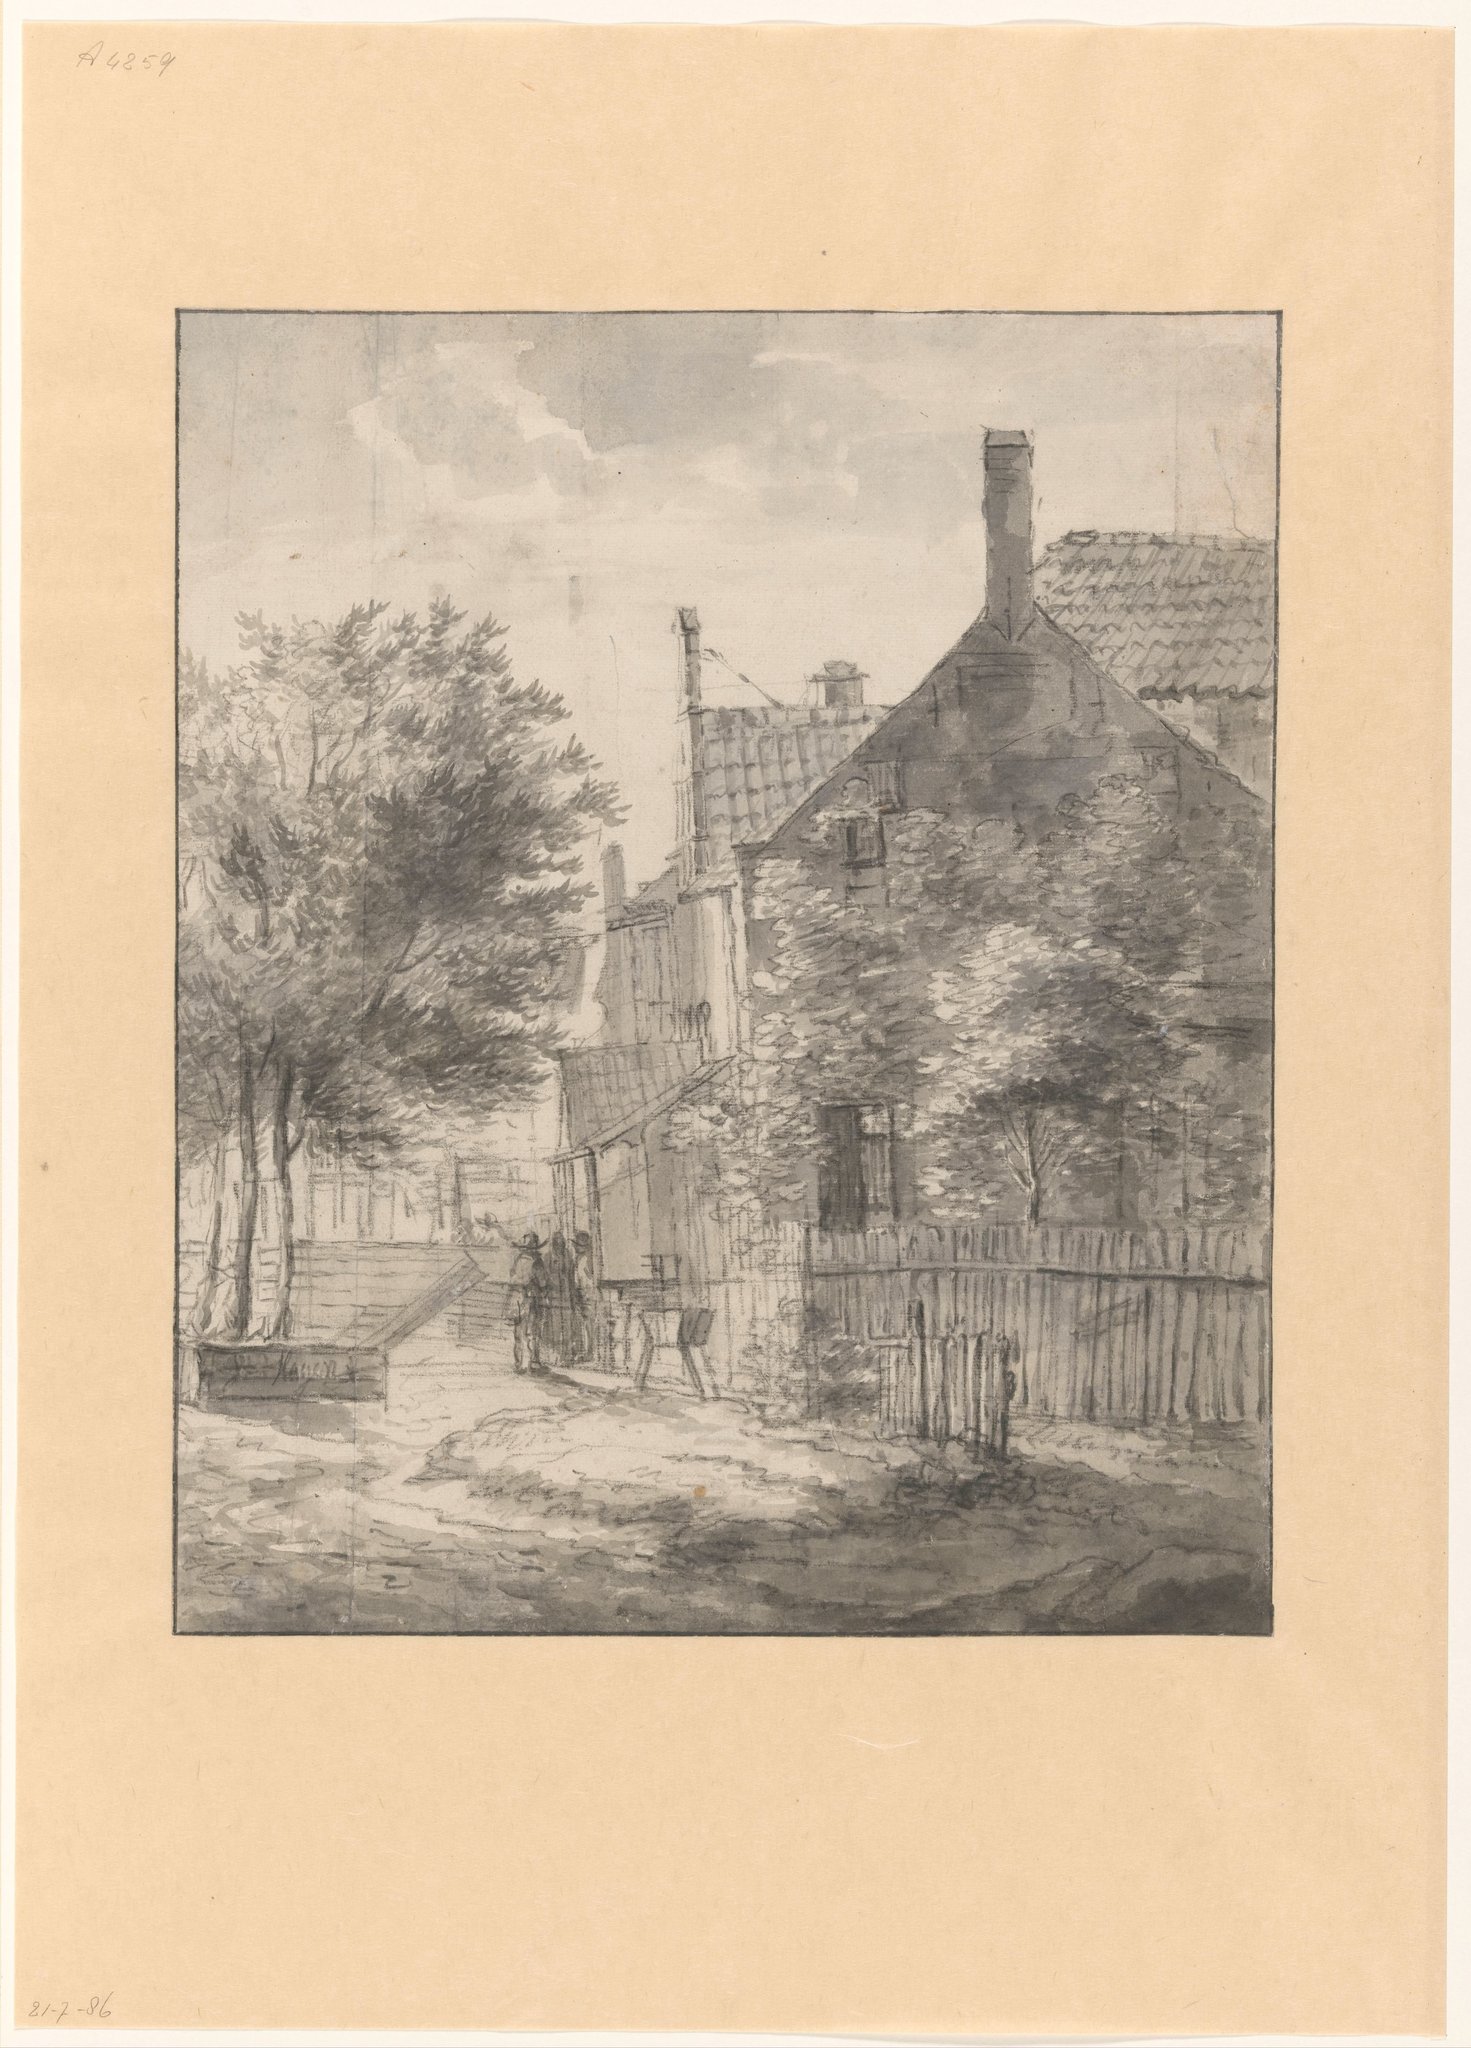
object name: drawing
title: Gezicht op een herberg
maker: joris van der haagen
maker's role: draughtsman, painter, print maker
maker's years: 1615-1669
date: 1625-1669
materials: chalk, paper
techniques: brush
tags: inn, coffee-house, public house, etc.